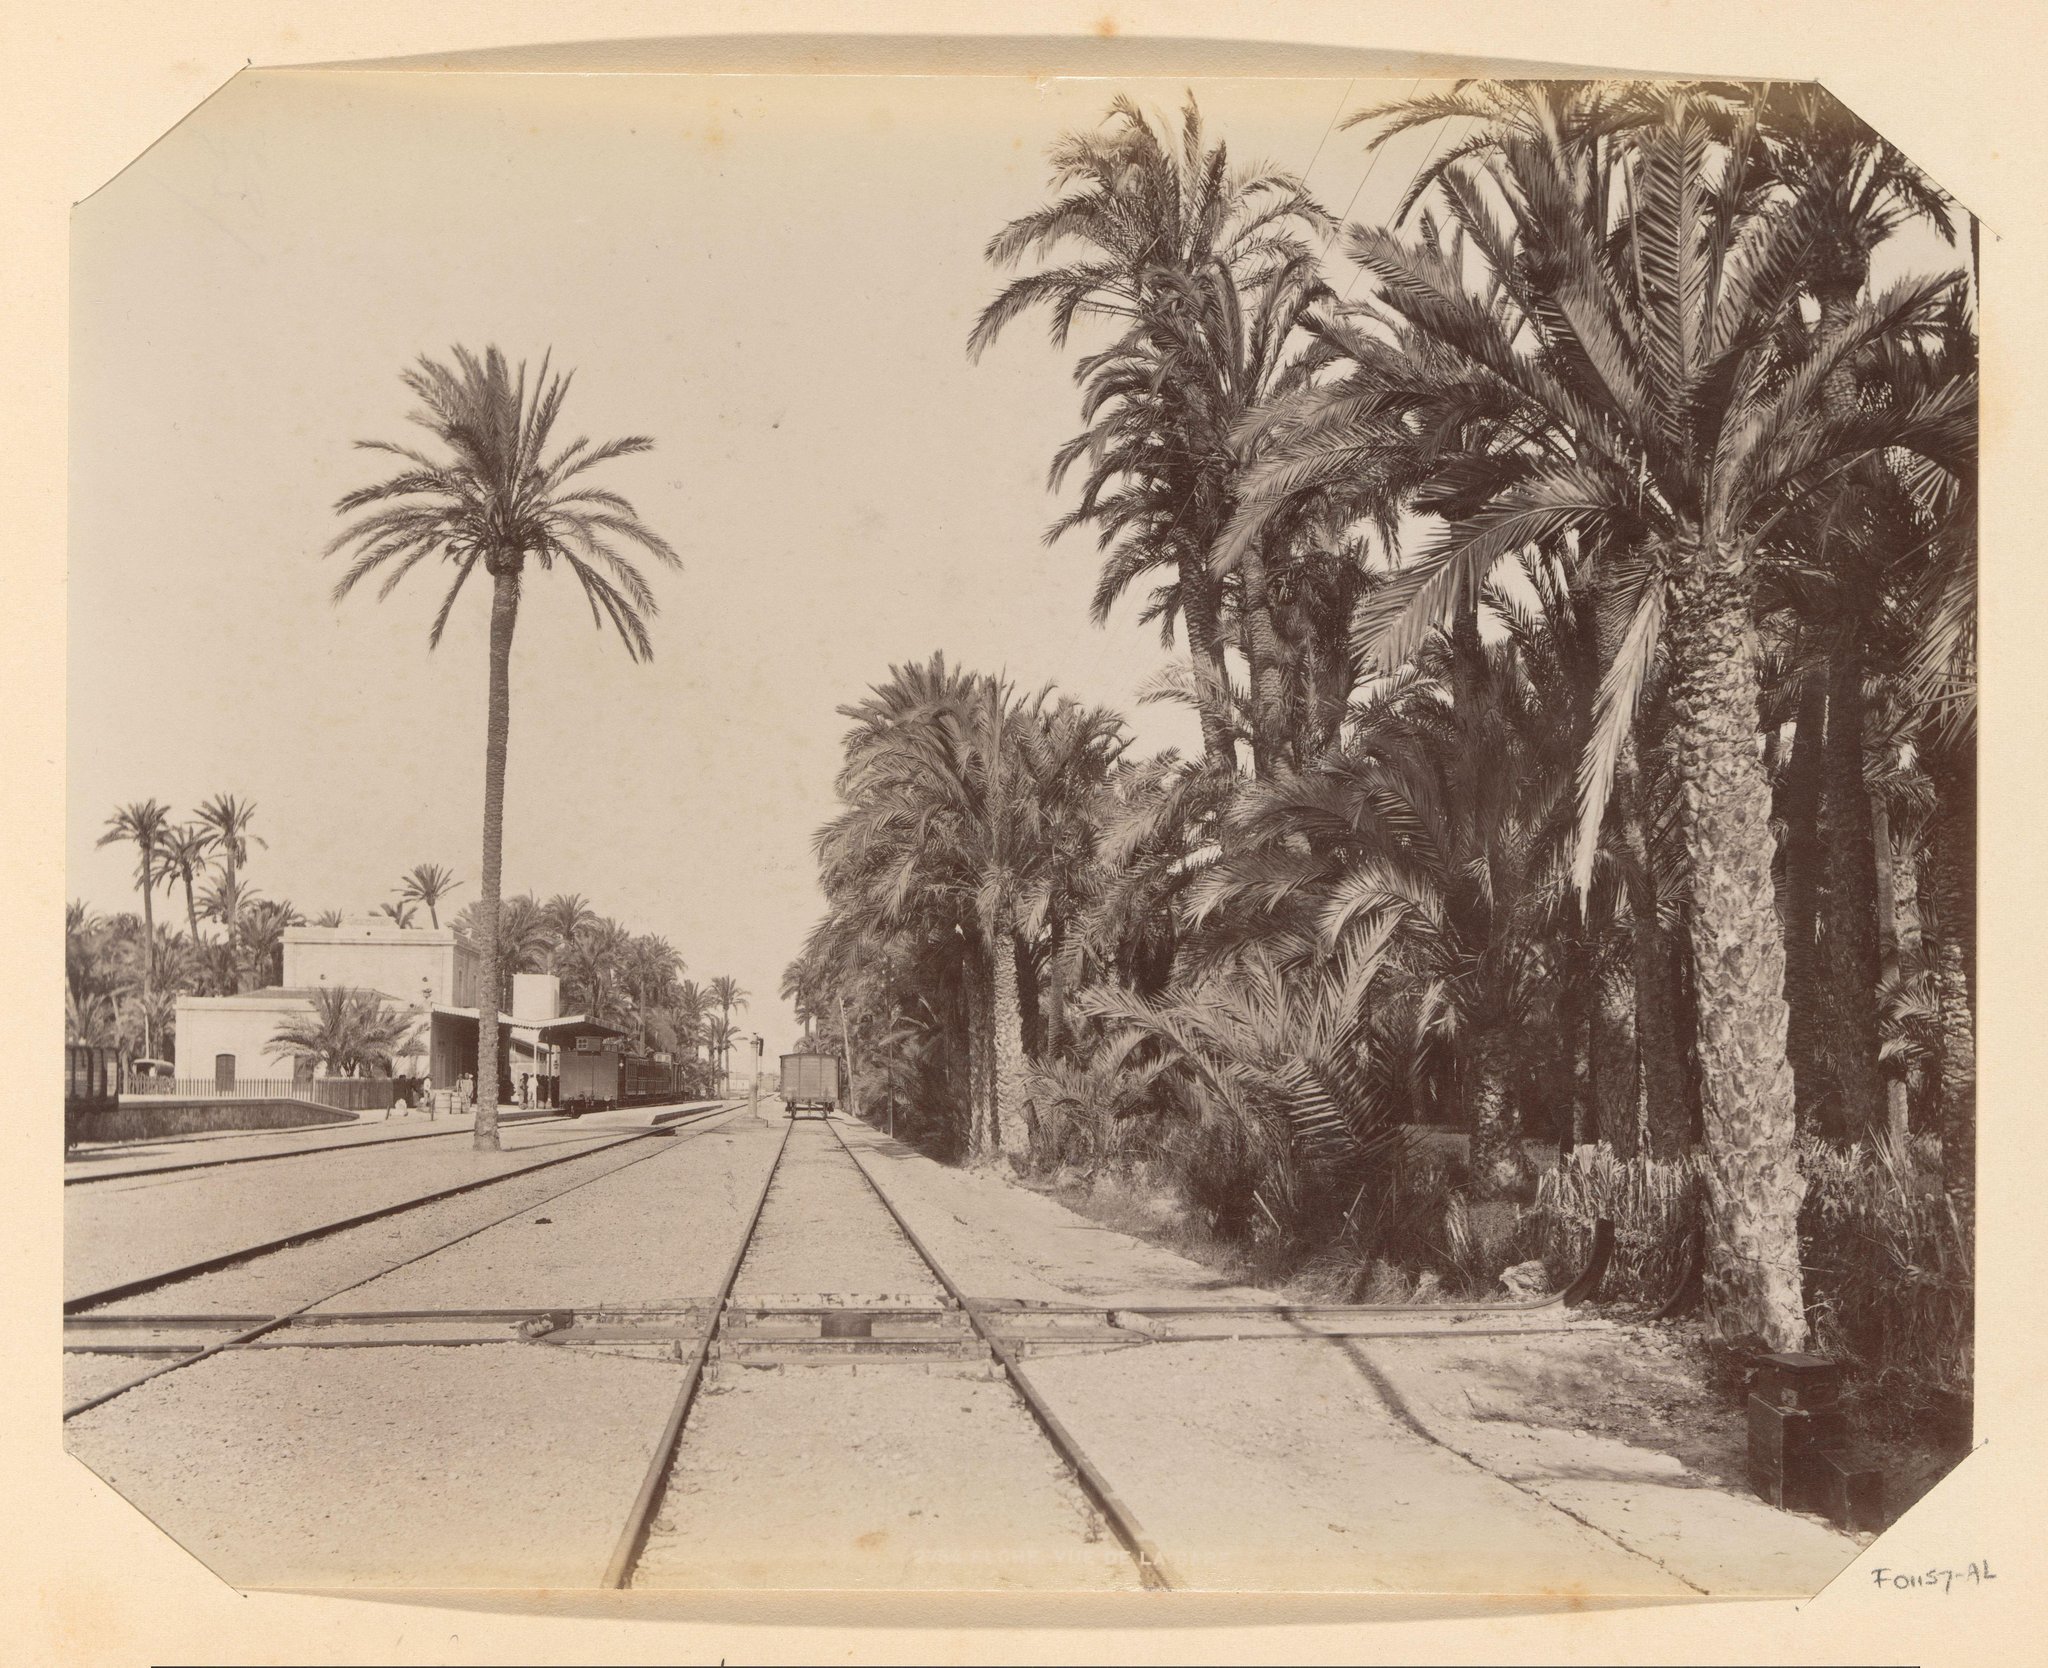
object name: album leaf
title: Station met rails te midden van palmen in Elx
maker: Anonymous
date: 1885-1892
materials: photographic support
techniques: albumen print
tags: trees: palm-tree, railway, tramway; rack railway, elche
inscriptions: annotation: ‘Elche - station’, number: ‘2784’